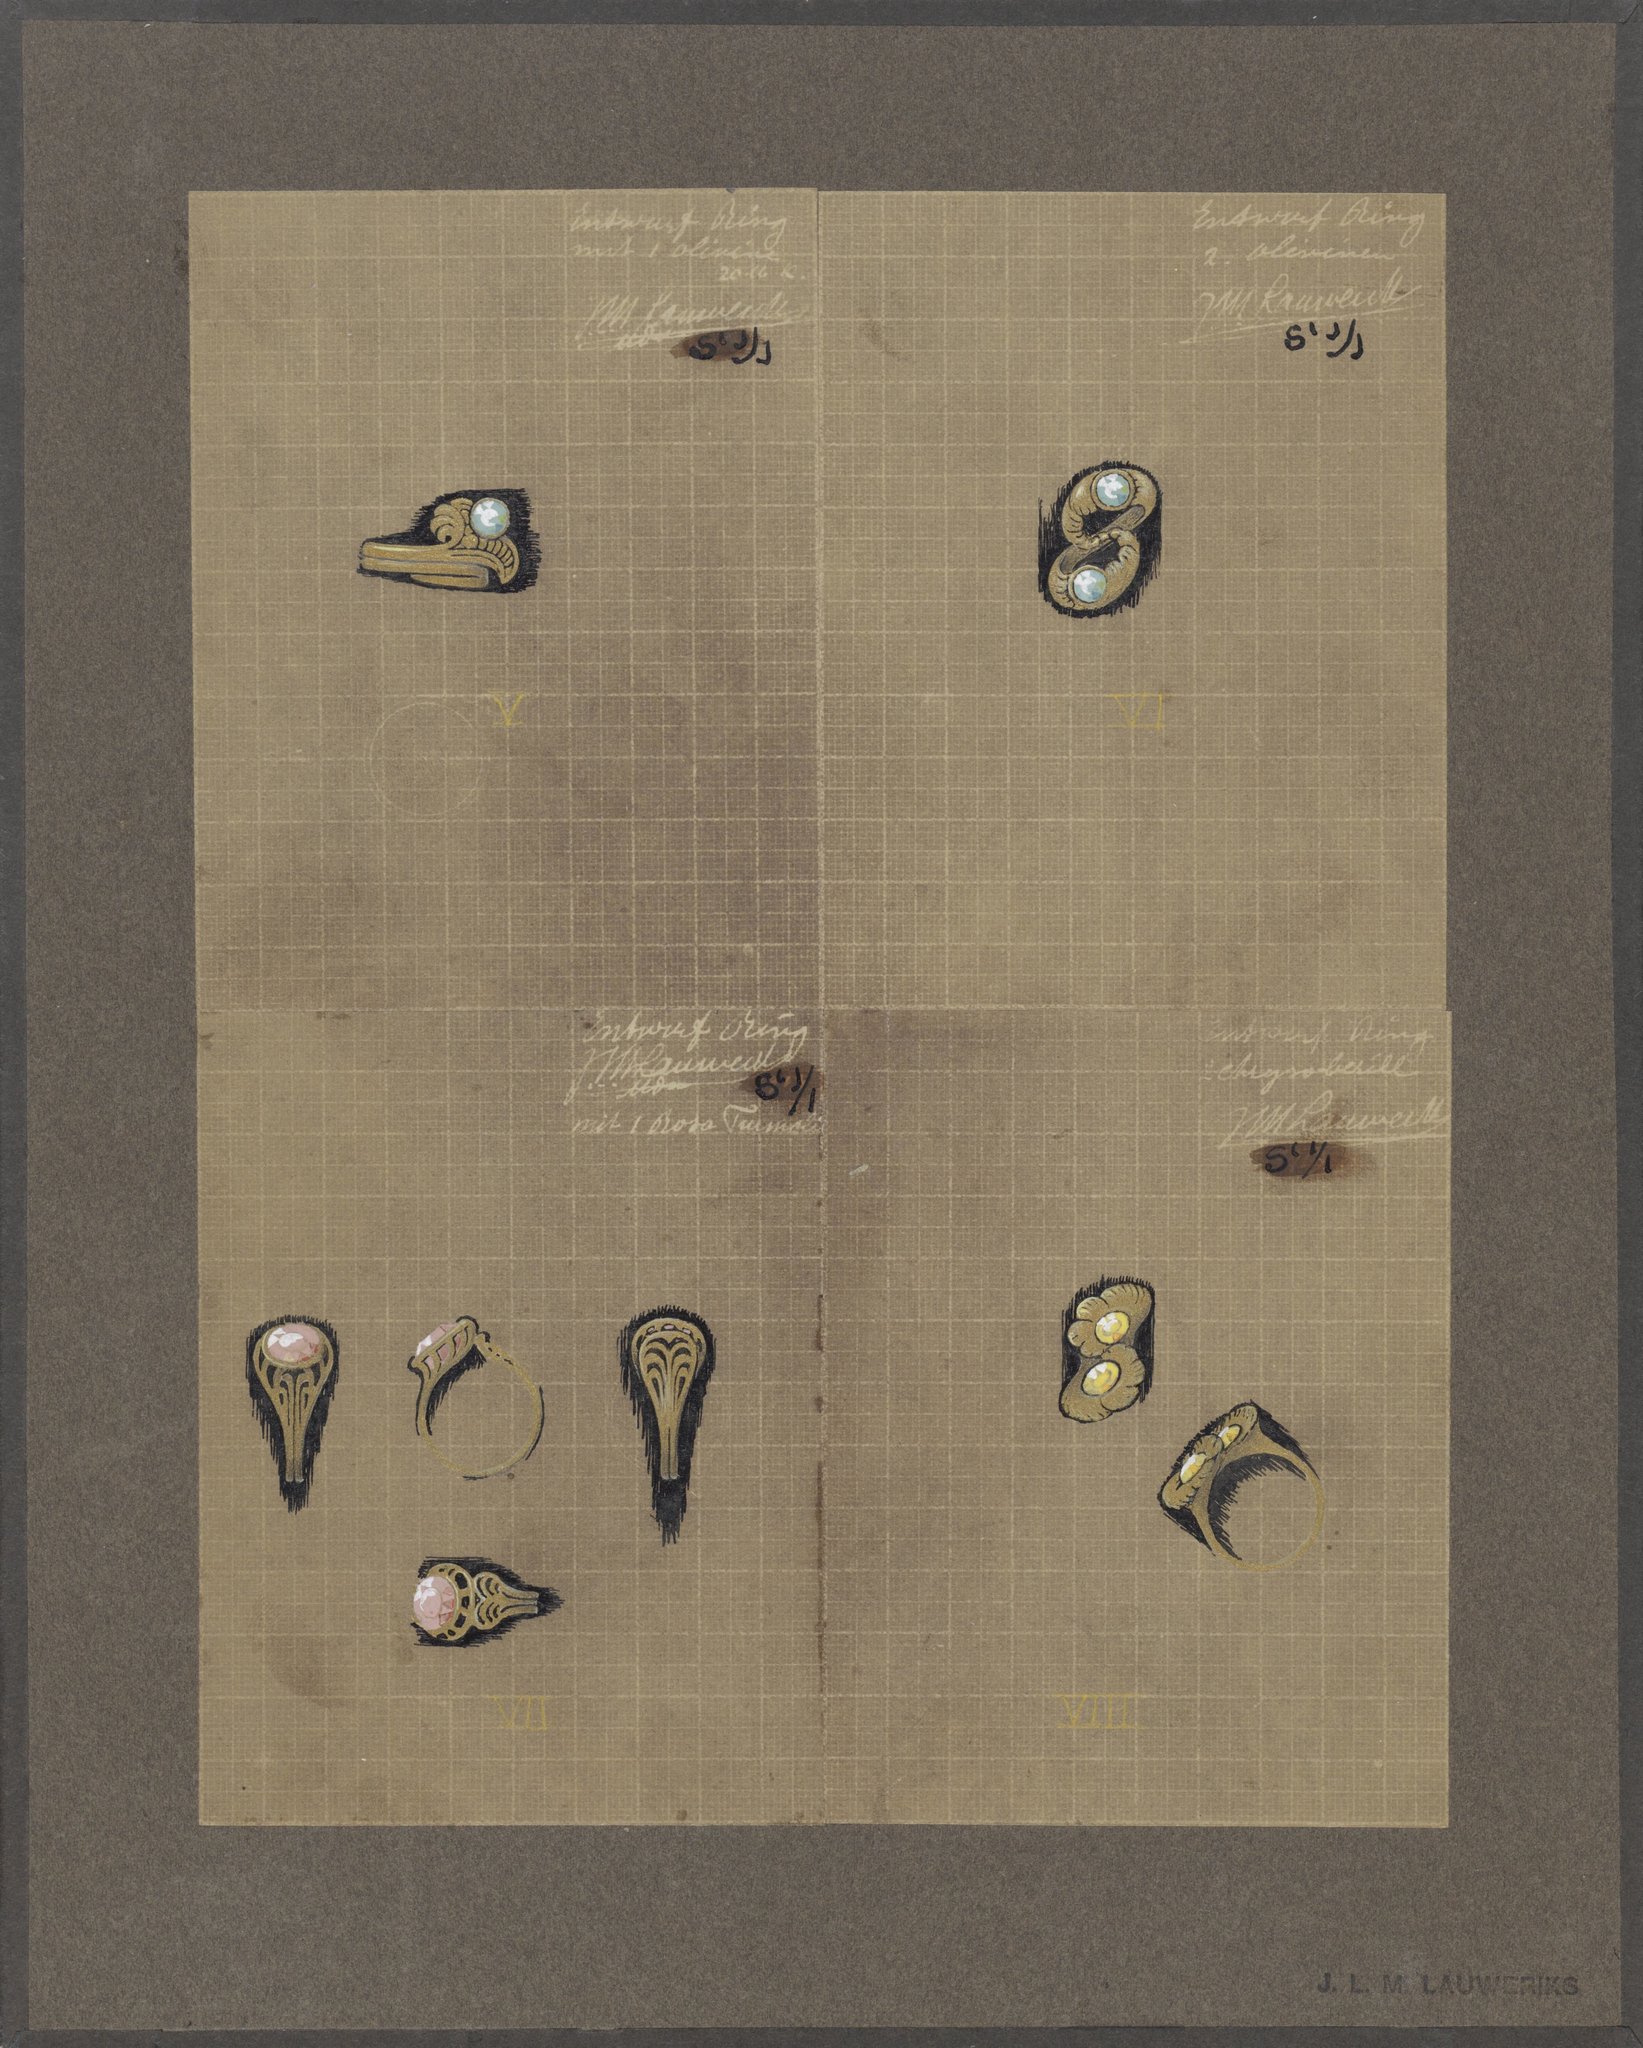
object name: design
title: Ingekleurde blauwdrukken van ringontwerpen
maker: mathieu lauweriks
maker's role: designer, draughtsman, print maker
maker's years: 1864-1932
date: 1874-1932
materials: cardboard, paint, ink, pencil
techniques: blueprint, brush, pen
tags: ring